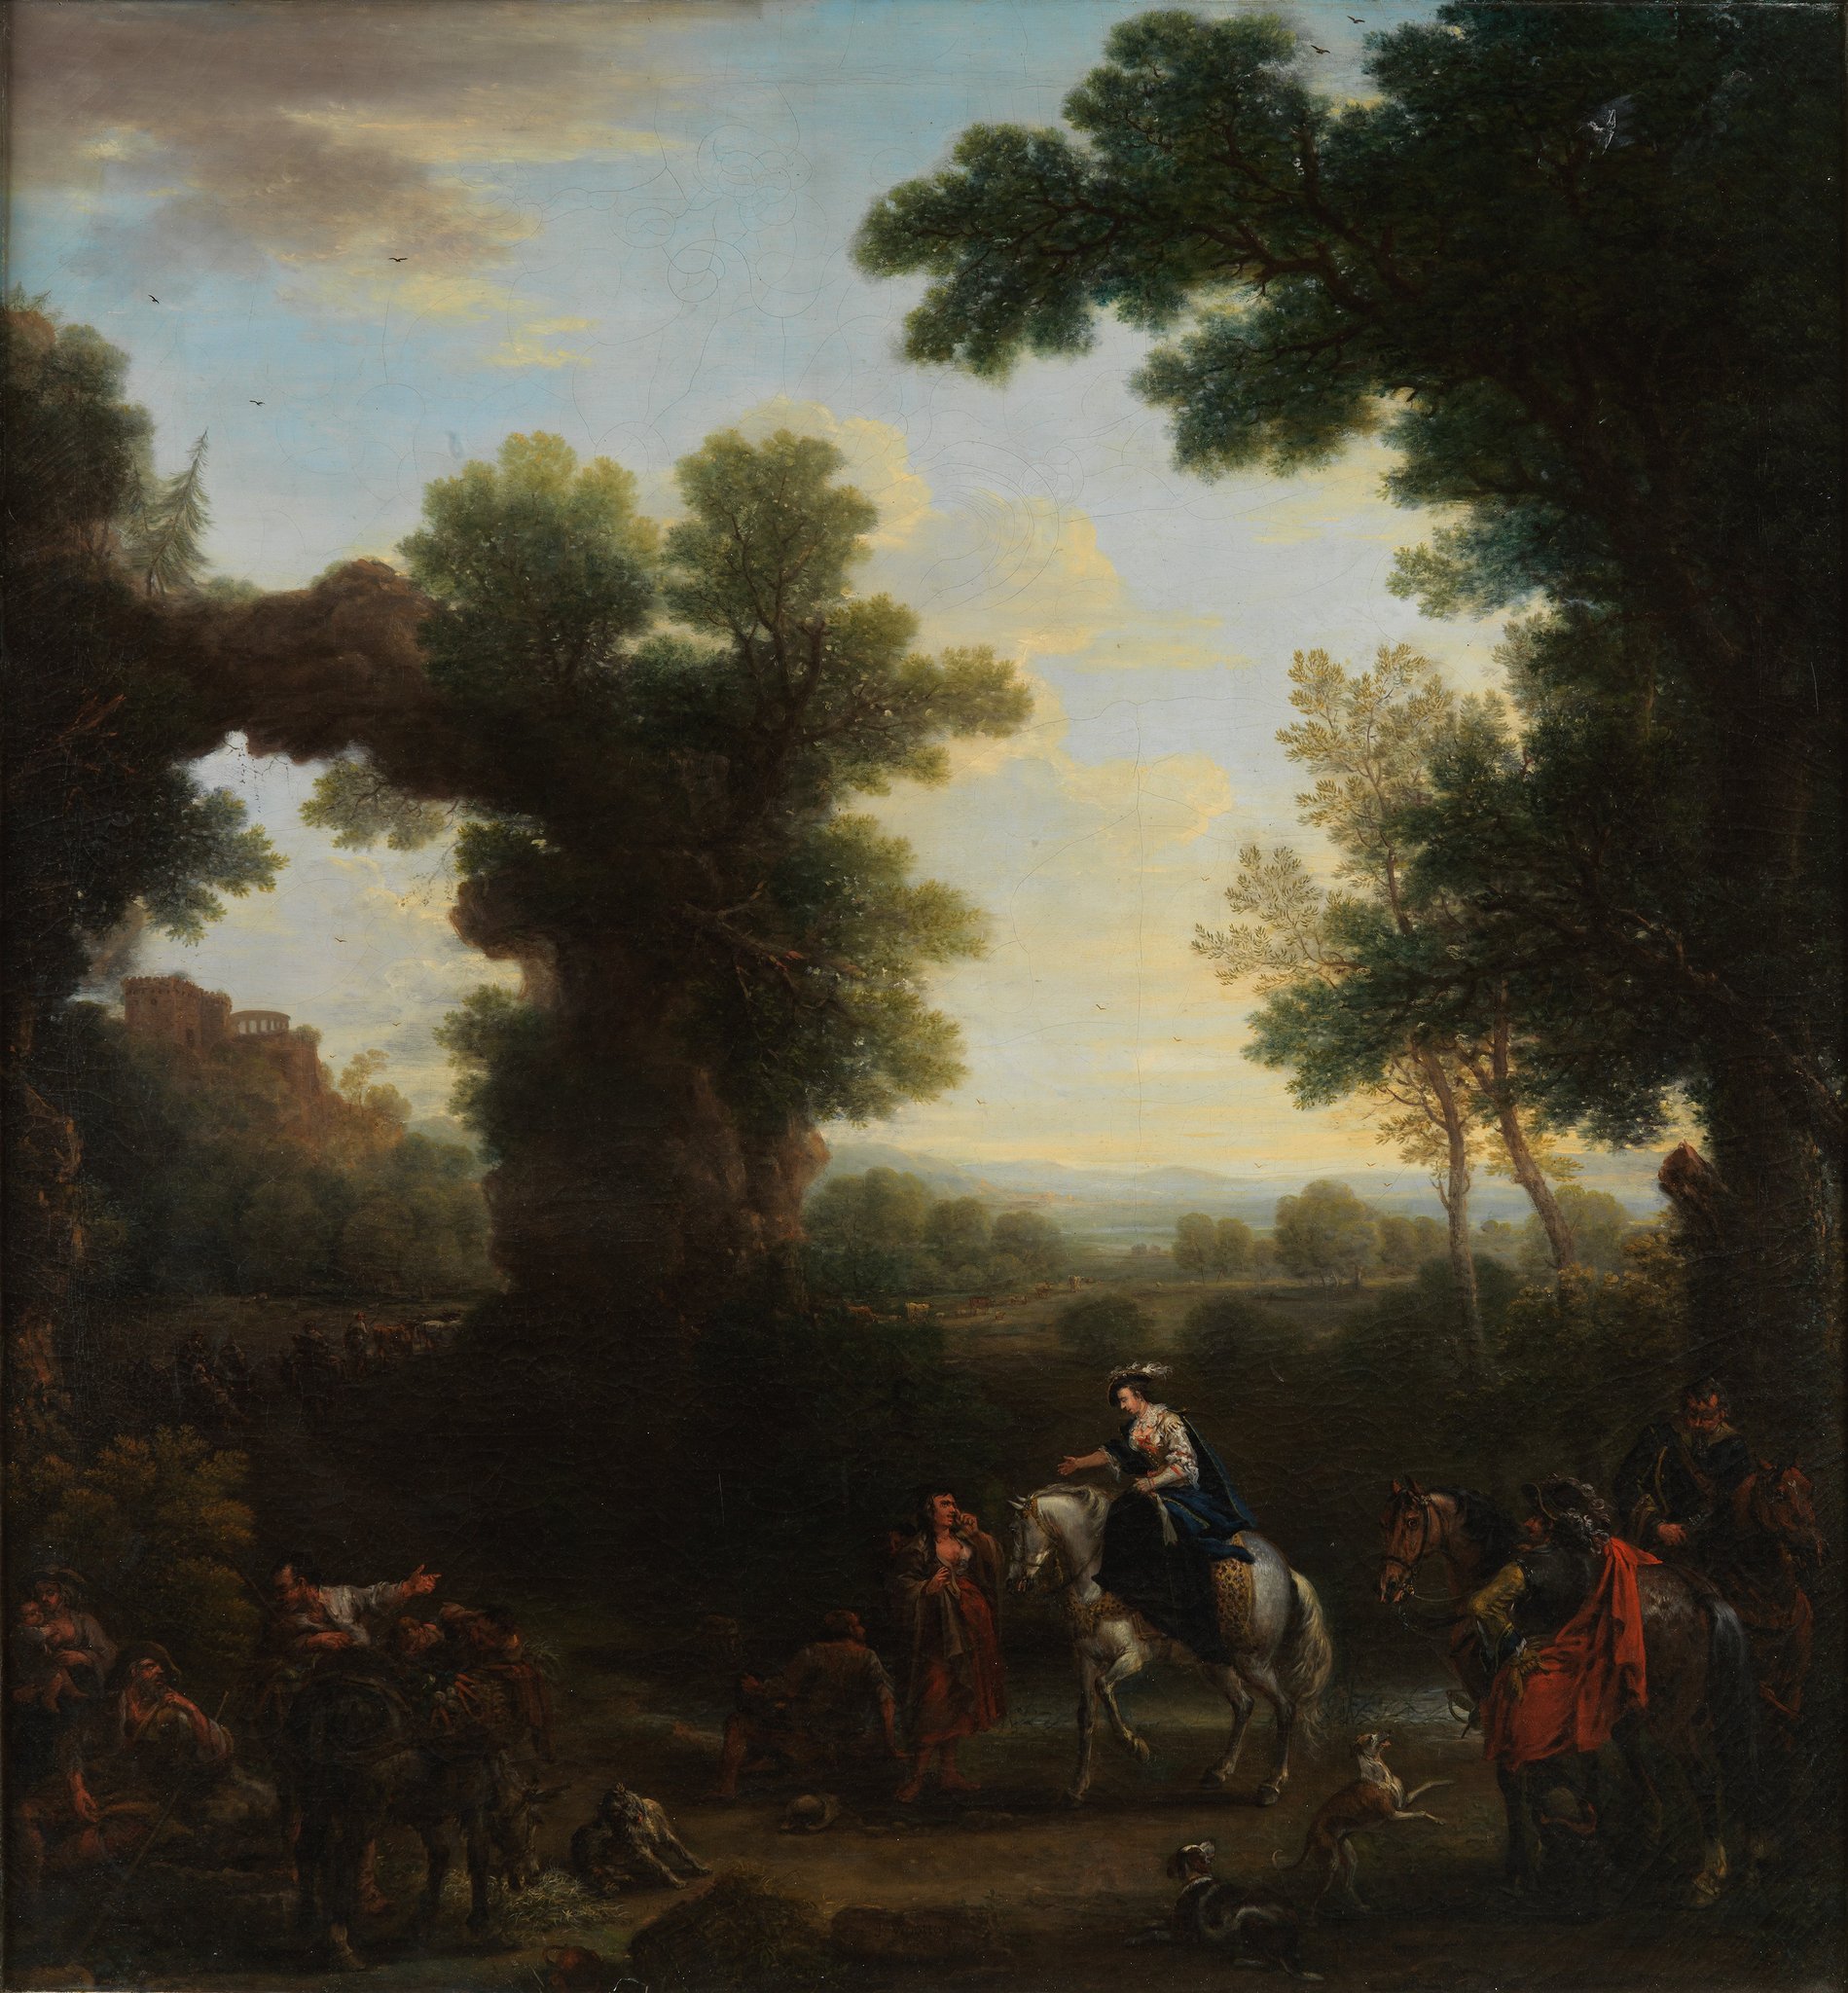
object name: painting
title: Classical Landscape with Roma Figures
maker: john wootton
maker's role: artist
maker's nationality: british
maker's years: 1681-1764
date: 1748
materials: canvas, oil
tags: men,dogs,horses,landscapes